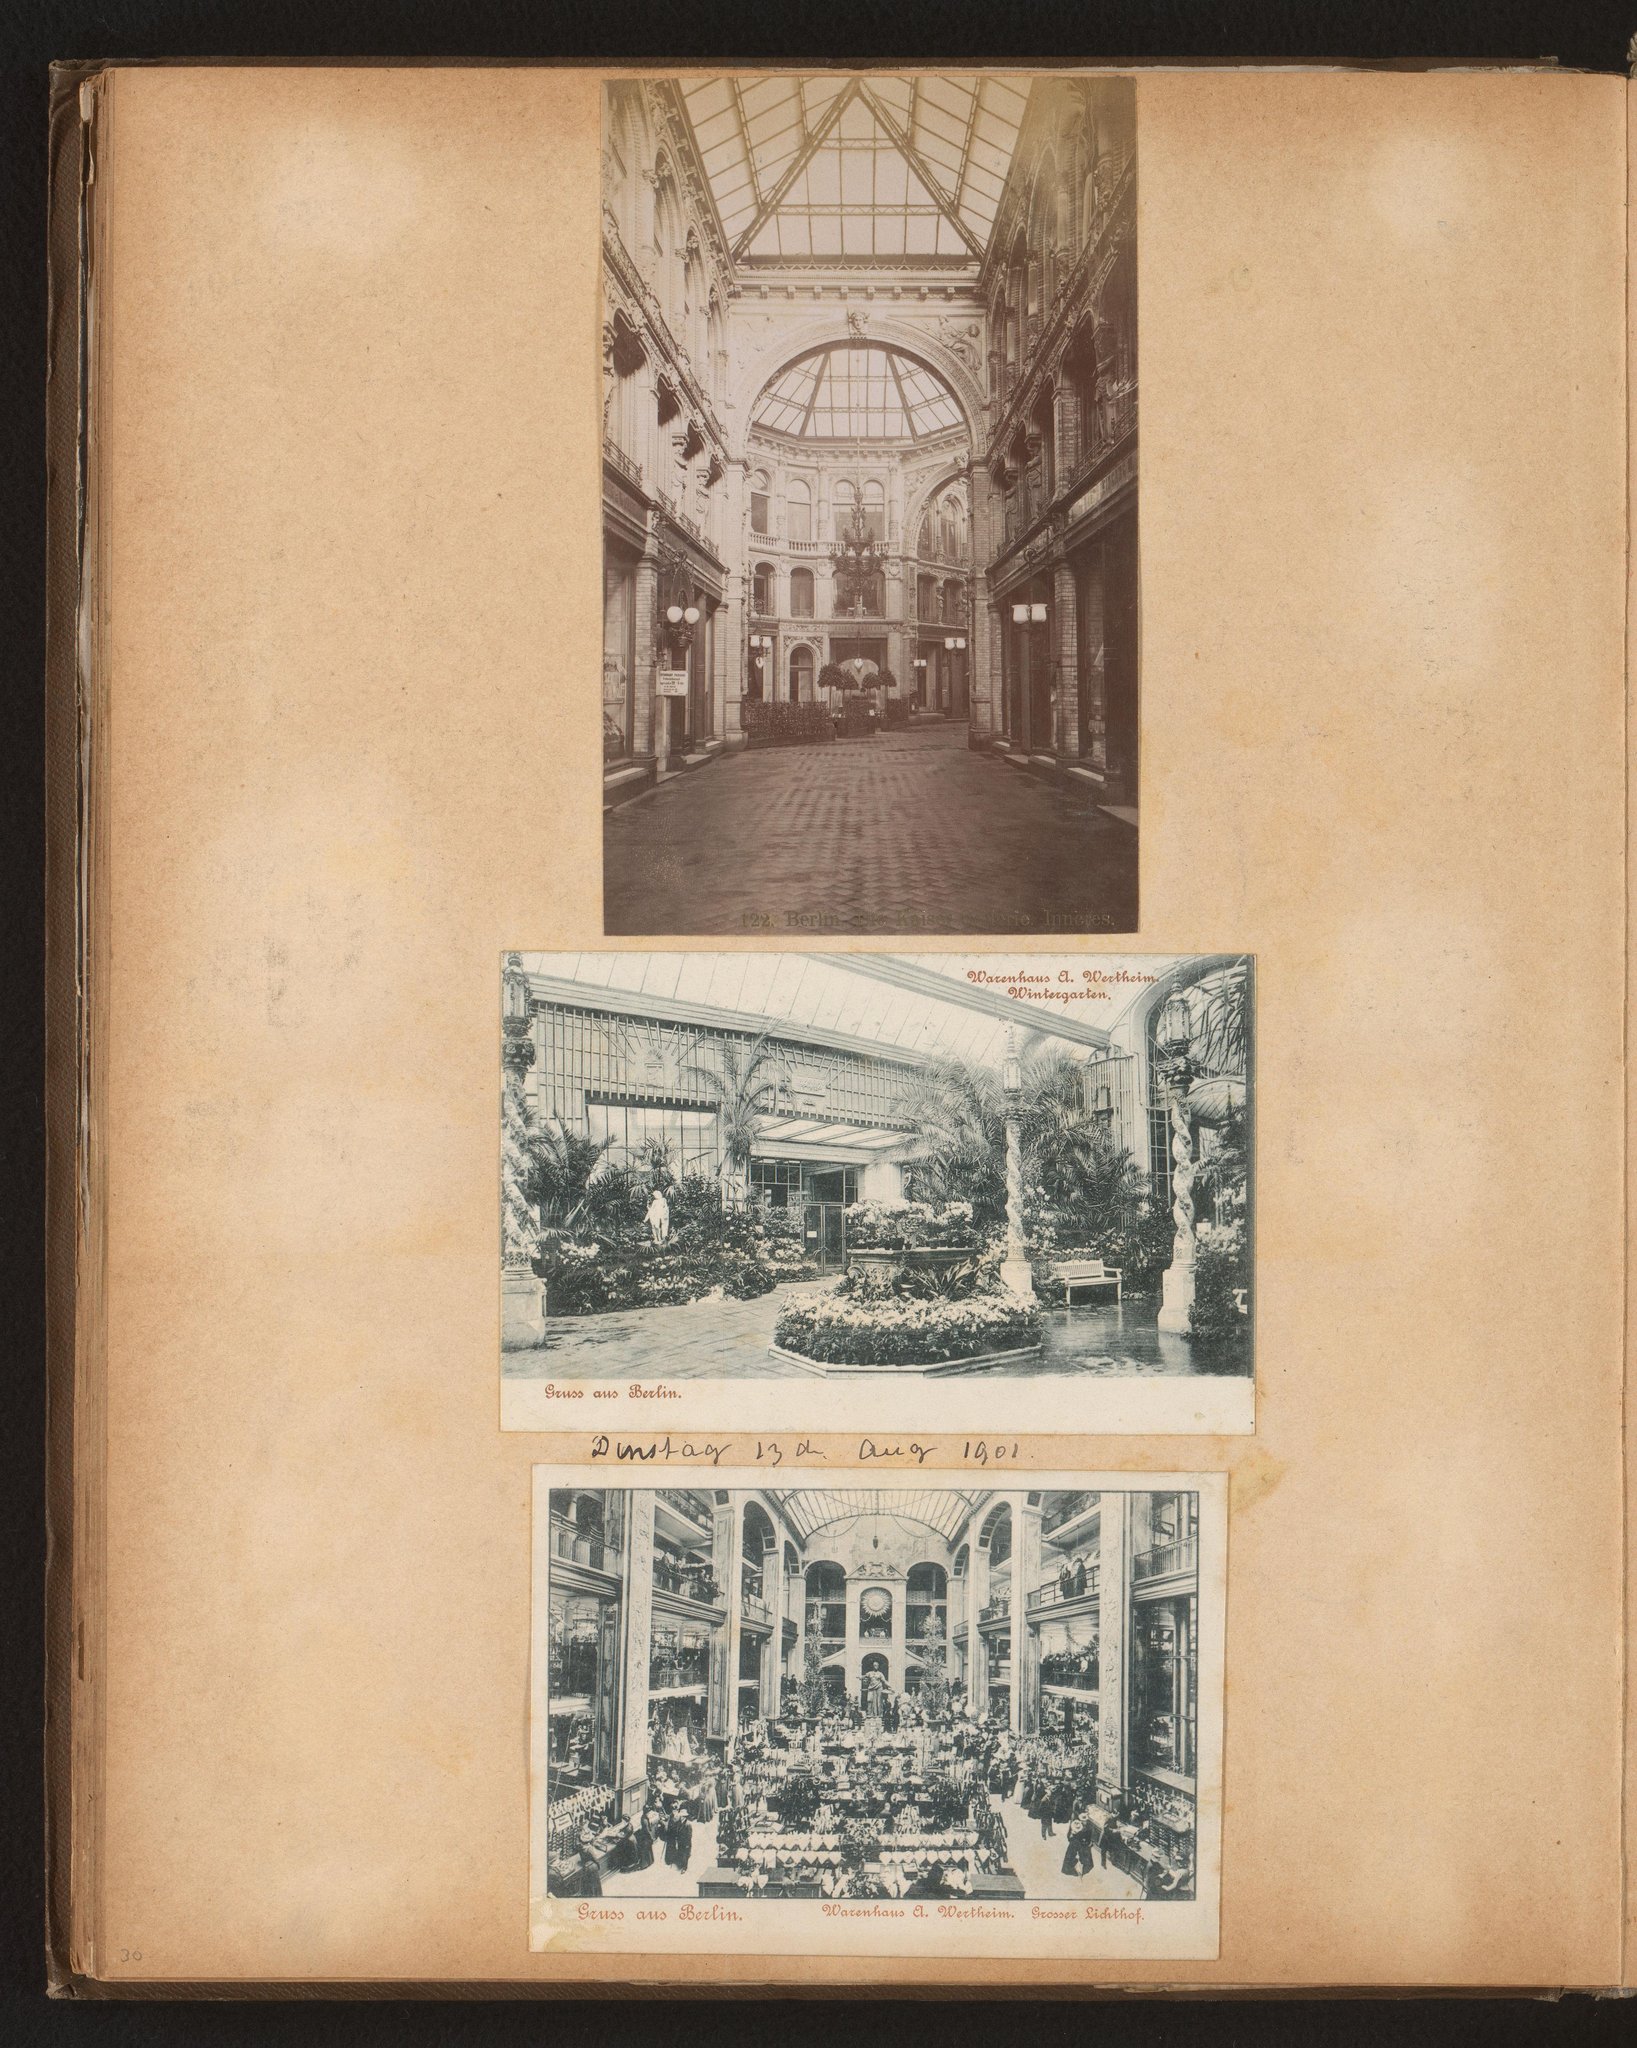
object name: photomechanical print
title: Drie aanzichten van de Kaisergalerie en warenhuis Wertheim, Berlijn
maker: Anonymous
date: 1896-1901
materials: cardboard, paper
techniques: albumen print, photograph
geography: berlin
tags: department store, supermarket, winter-garden, conservatory, gallery (spacious corridor), berlin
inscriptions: inscription: ‘Warenhaus A. Wertheim./ Wintergarten./ Gruss aus Berlin.’, title: ‘122. Berlin. Die Kaiser-Gallerie. Inneres.’, inscription: ‘Gruss aus Berlin. Warenhaus A. Wertheim. Grosser Lichthof.’, inscription: ‘Dinsdag 13de Aug: 1901’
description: Deze foto en fotomechanische afdrukken maken deel uit van een album.